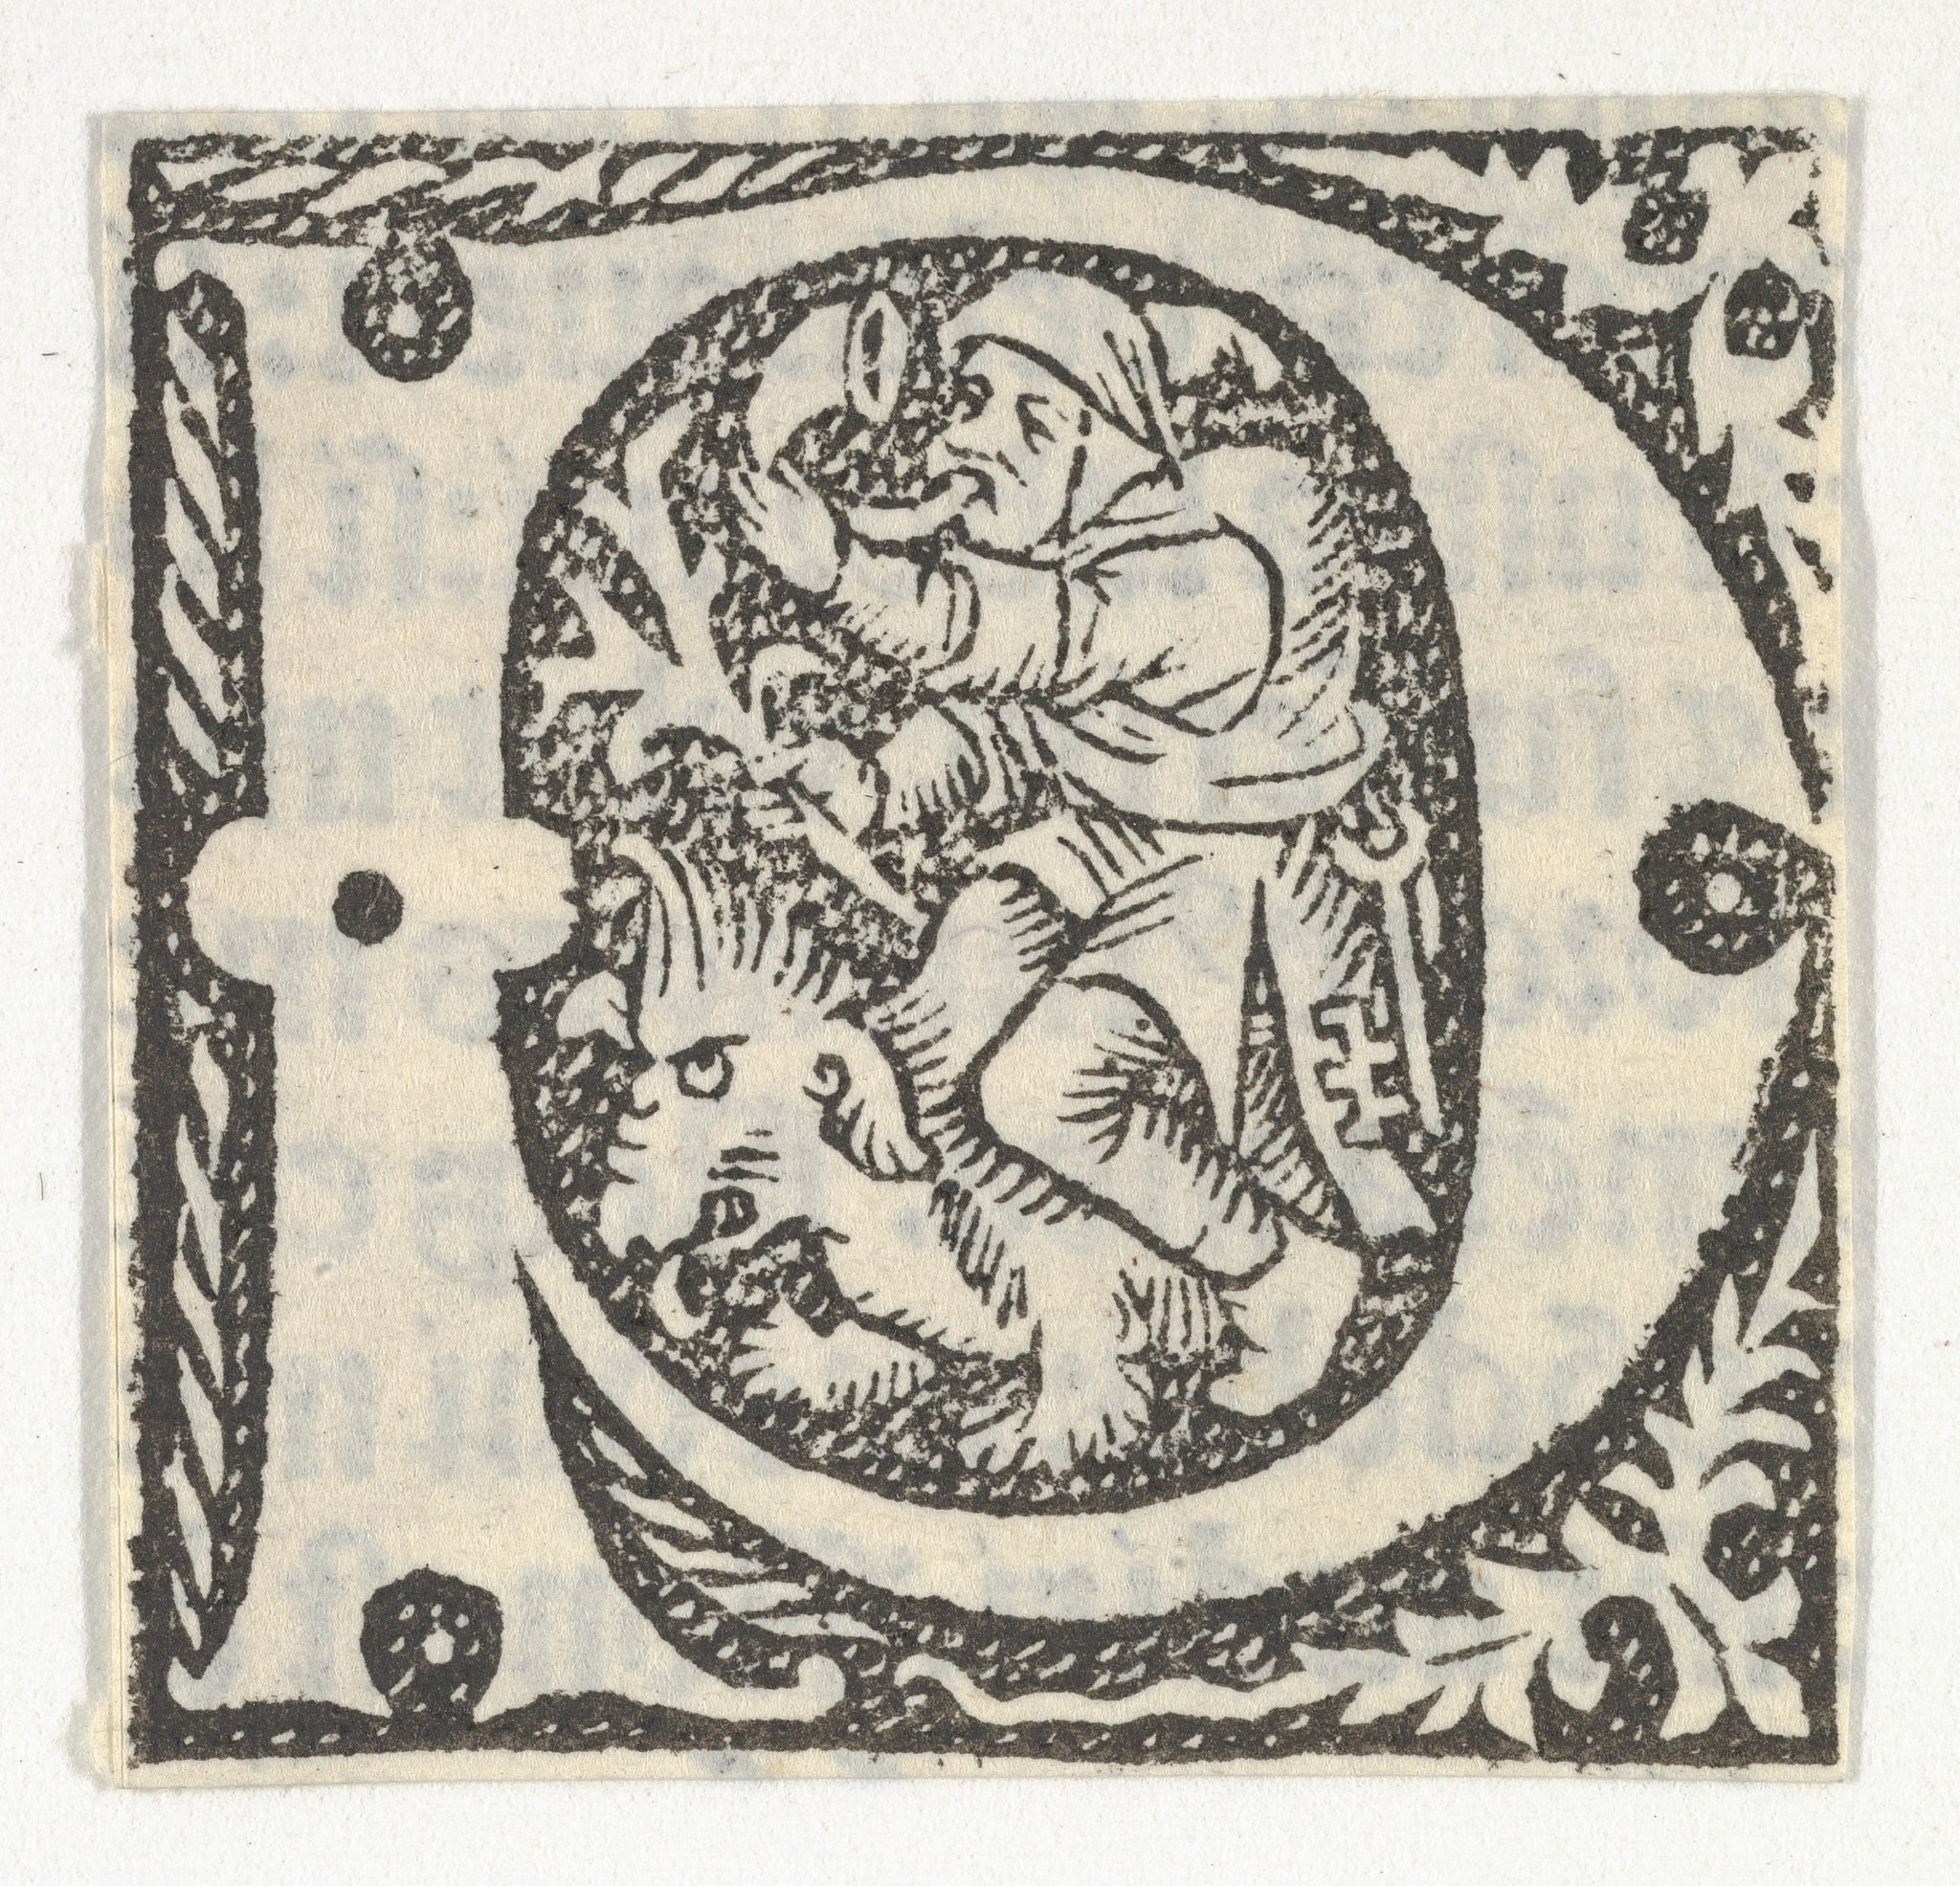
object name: print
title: Decorated Roman alphabet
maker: anonymous, french, 15th century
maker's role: artist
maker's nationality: french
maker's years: 1400-1500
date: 1499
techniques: woodcut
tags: men